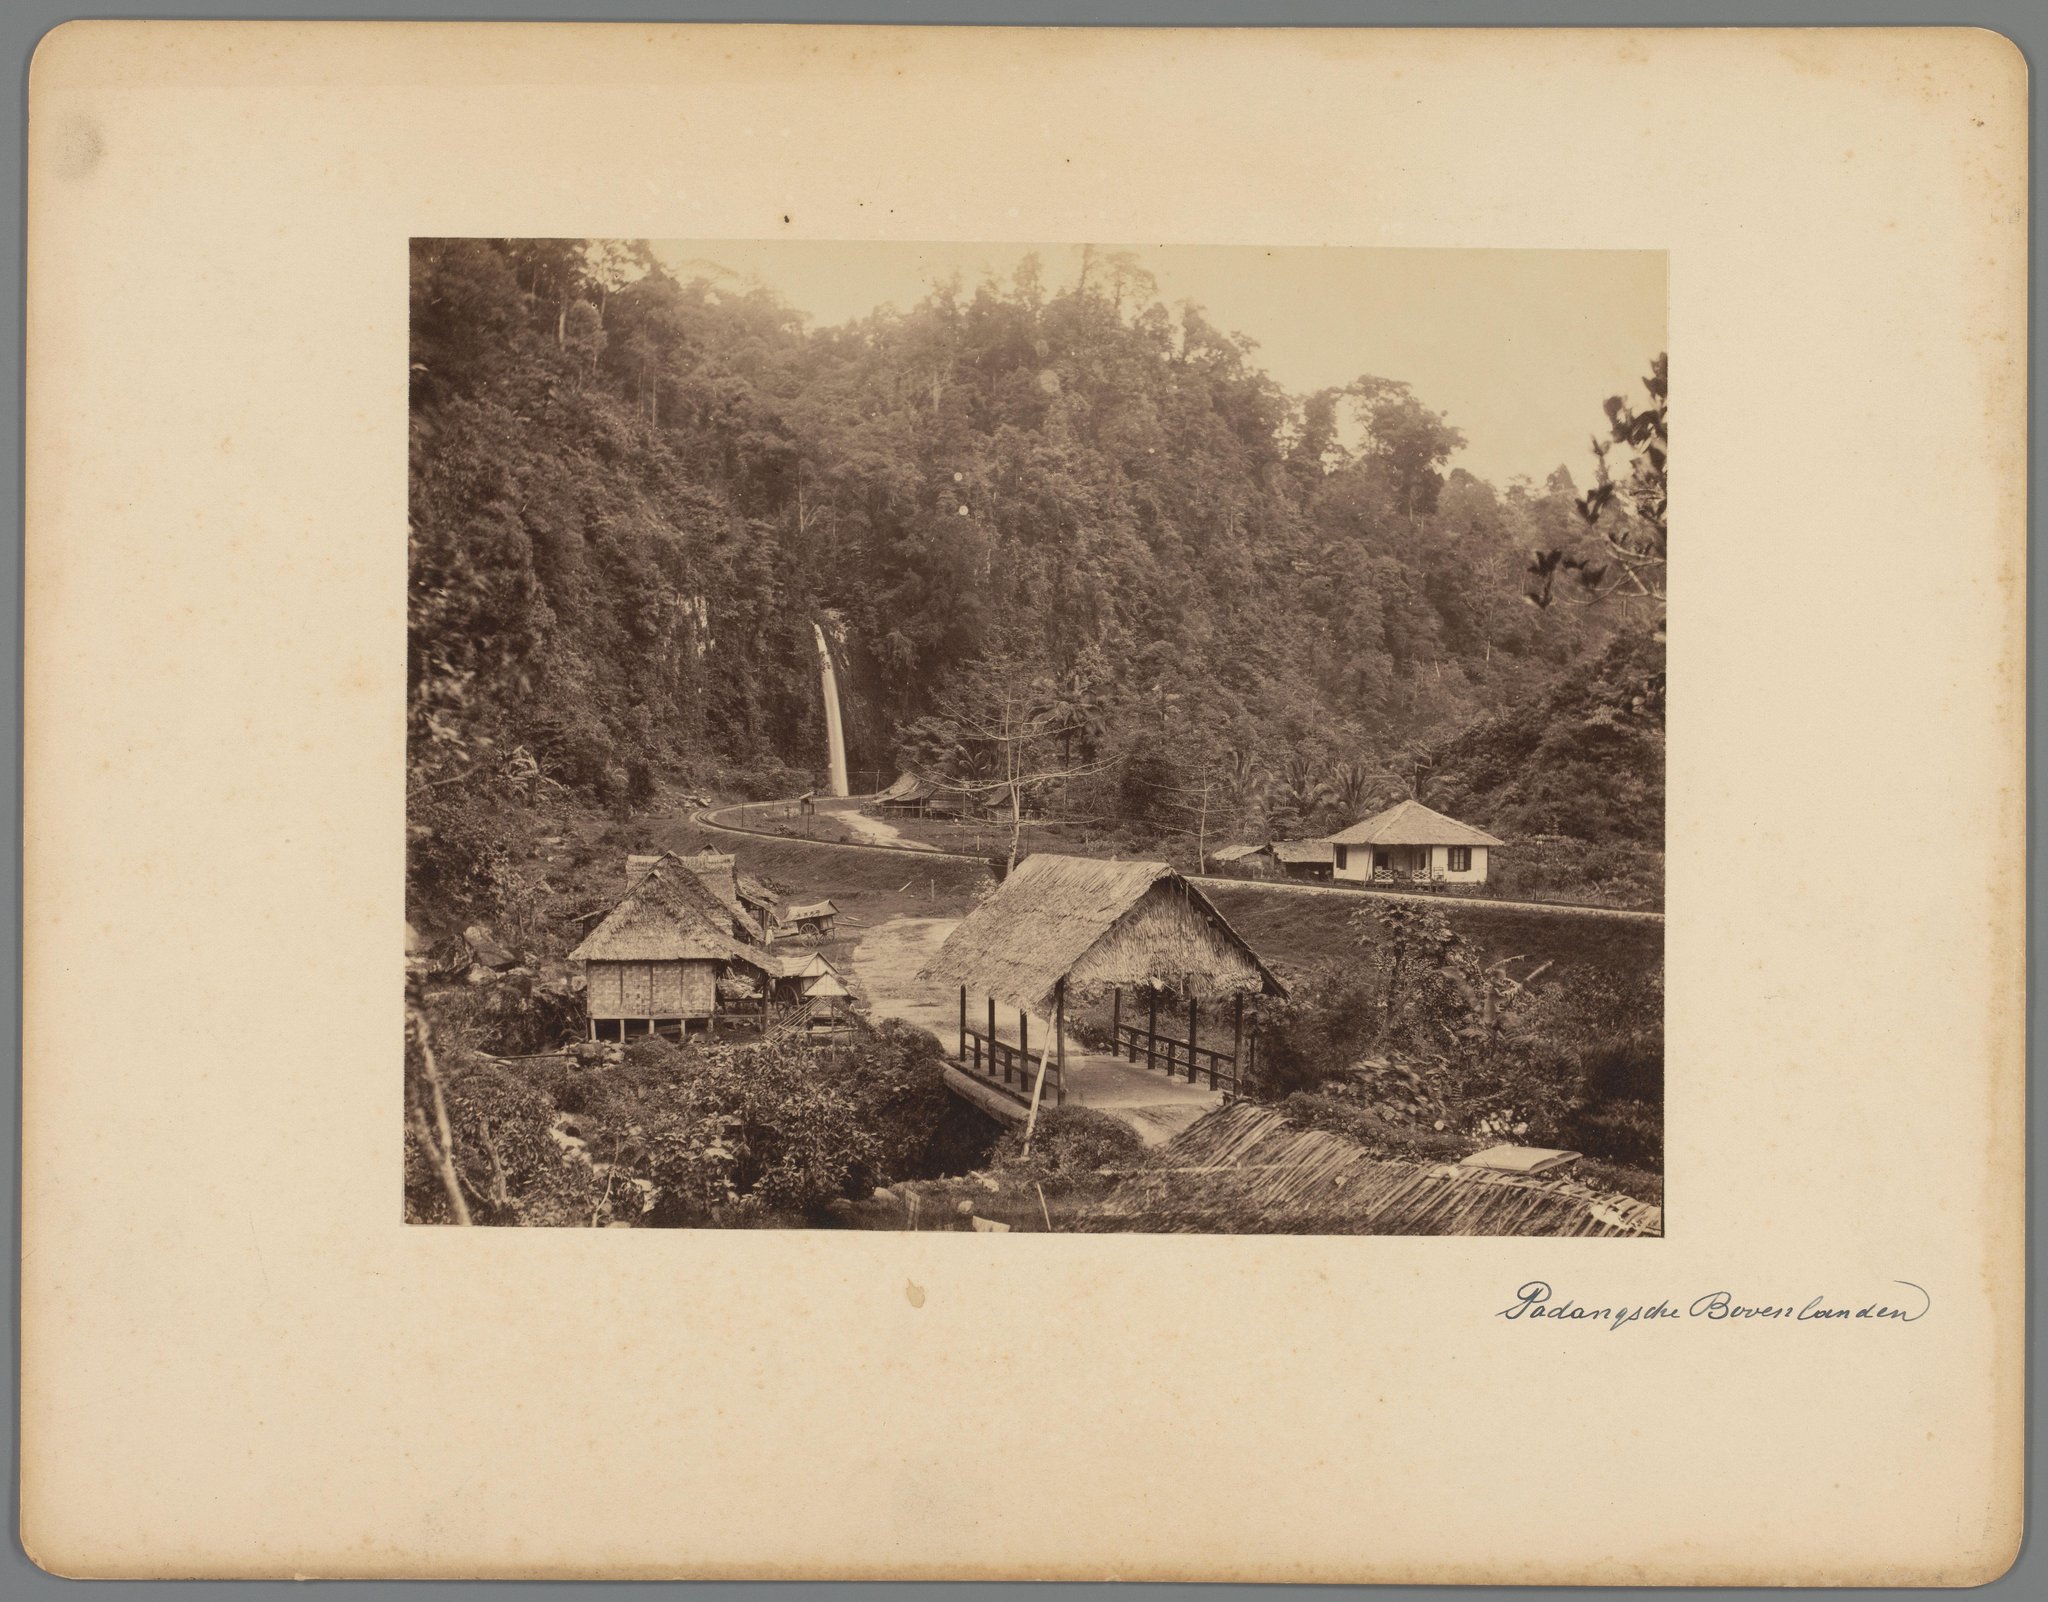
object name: photograph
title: Dorp met spoorlijn, West-Sumatra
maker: christiaan benjamin nieuwenhuis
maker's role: publisher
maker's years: 1863-1922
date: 1891-1895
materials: cardboard, paper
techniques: albumen print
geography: sumatera barat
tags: village, railway, train, sumatera barat (province)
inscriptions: inscription: ‘Foto’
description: Deze foto zat oorspronkelijk in prentenkabinet RP-F-AA3192.